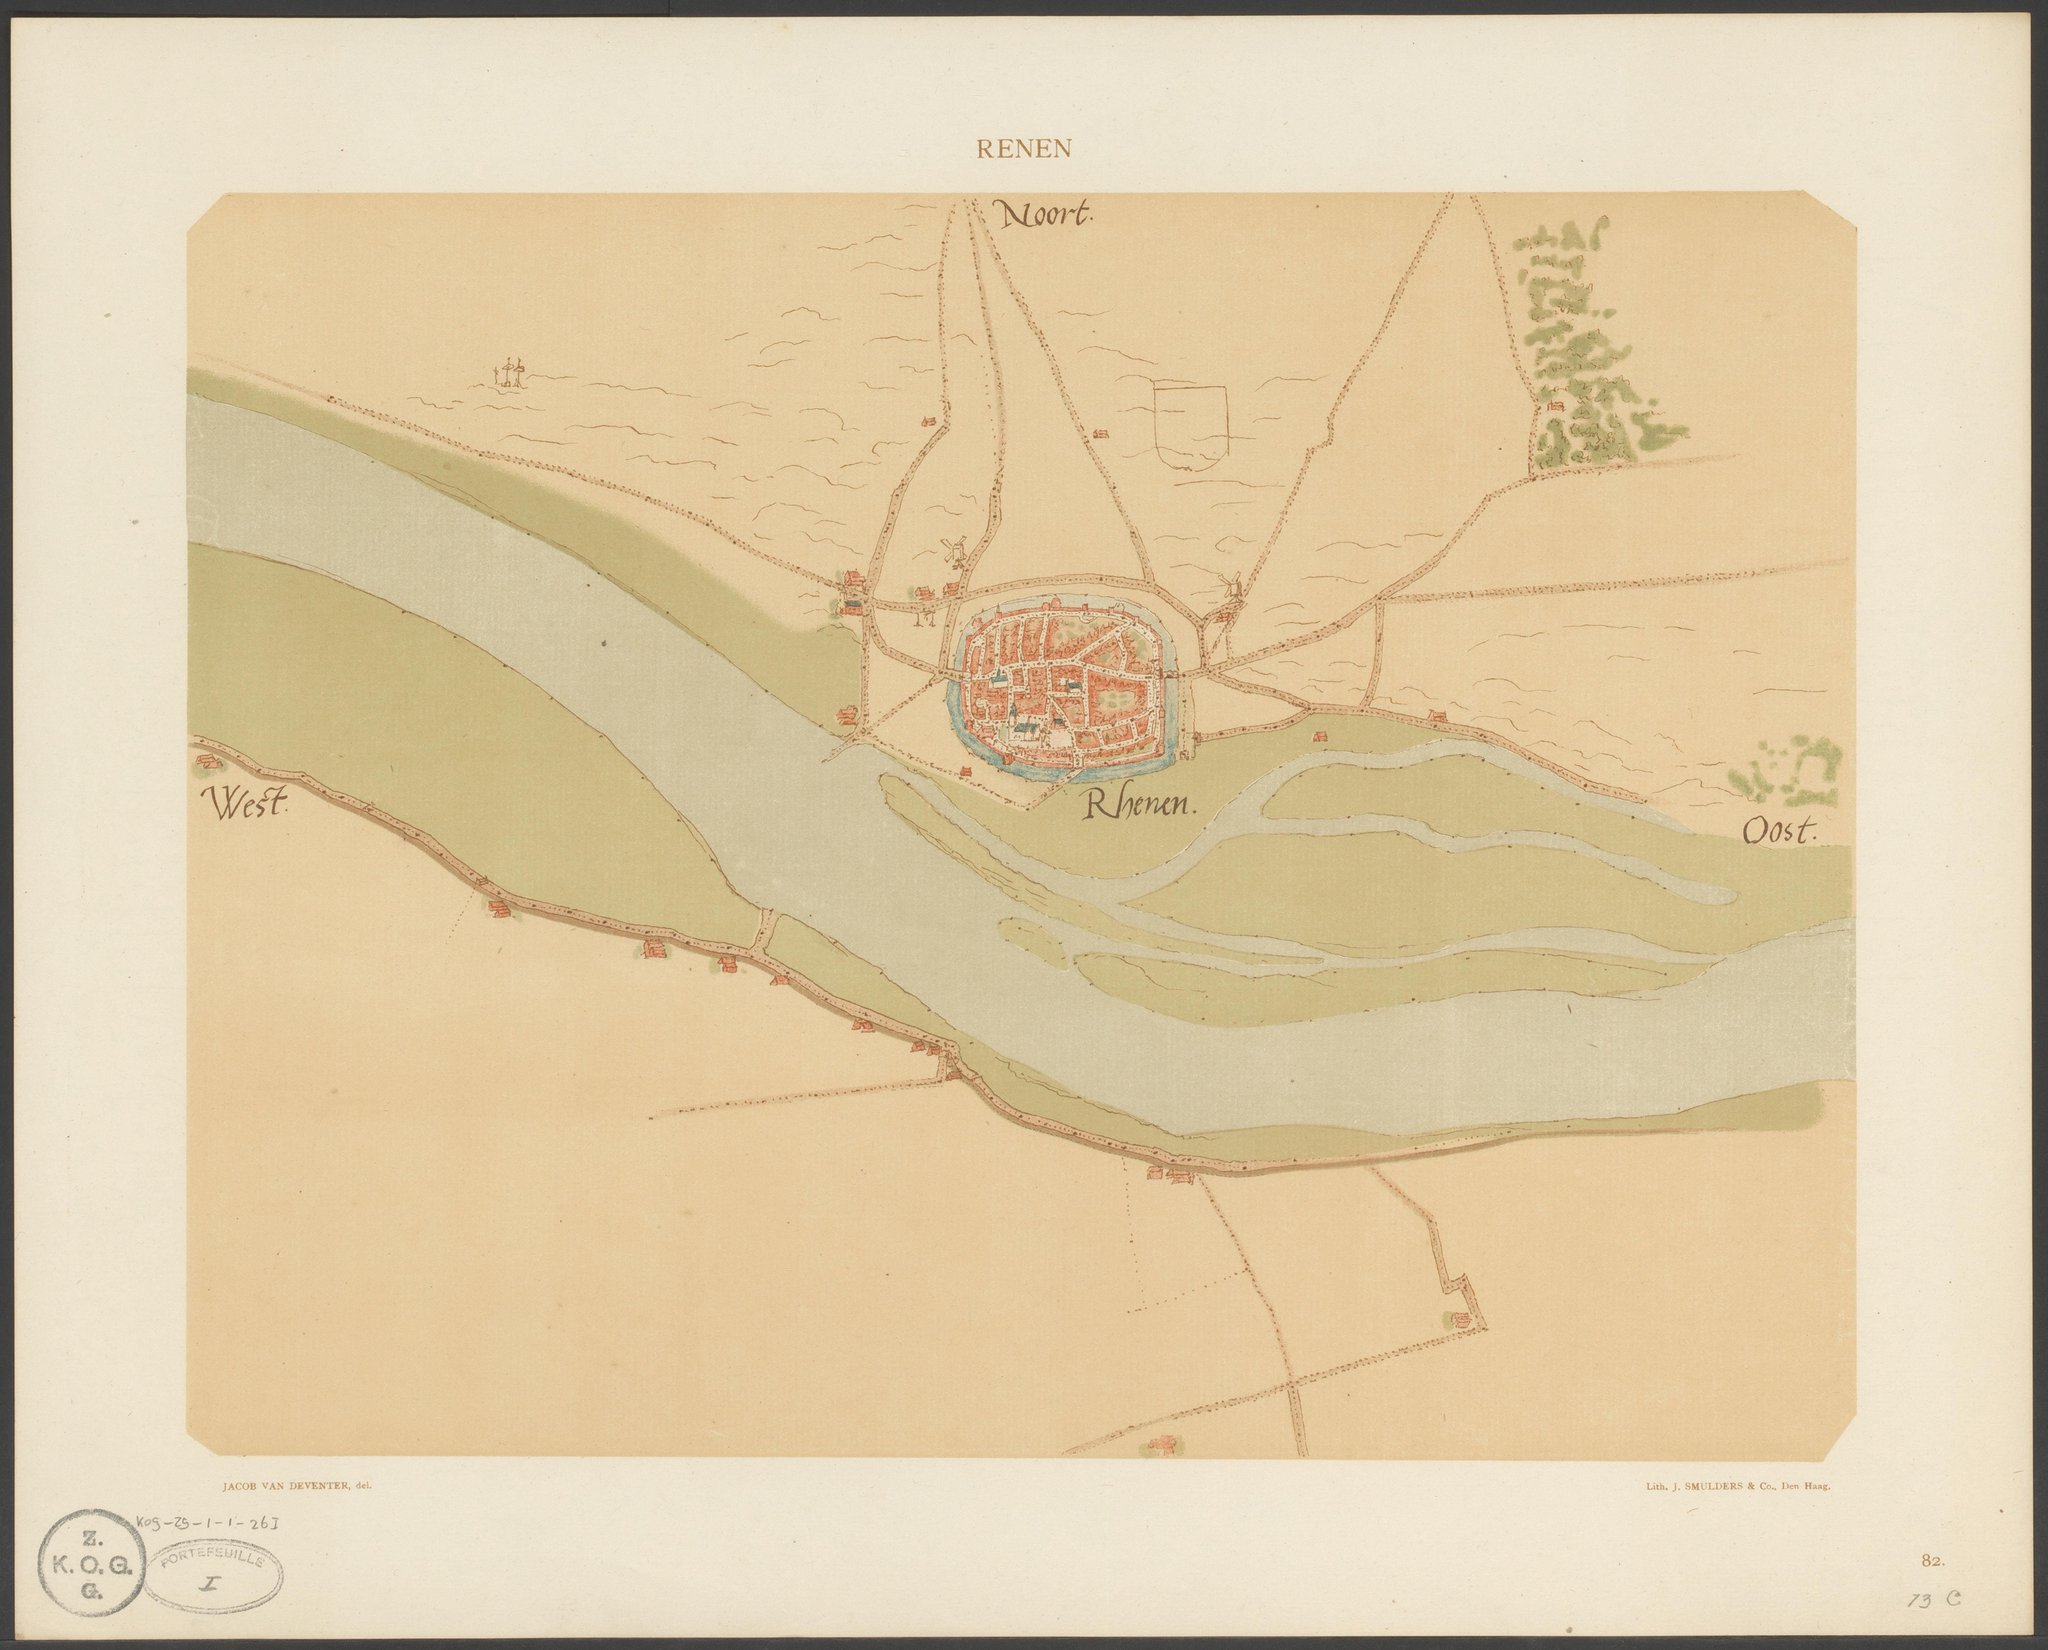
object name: print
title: Nederlandsche Steden in de 16e eeuw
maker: jacob van deventer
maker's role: draughtsman, print maker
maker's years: 1510-1575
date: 1916-1923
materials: paper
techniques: lithograph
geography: the hague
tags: maps of cities, rhenen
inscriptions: collector's mark, collector's mark: Lugt 1641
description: Plattegrond van de stad Rhenen. Genummerd rechtsonder: 82. Onderdeel van een serie 'Nederlandsche Steden in de 16e eeuw', reproducties naar de oorspronkelijke topografische tekeningen van Jacob van Deventer. Onderwerpsrubrieken binnen de Atlas Zeden en Gewoonten: topografie; stadsplattegronden.